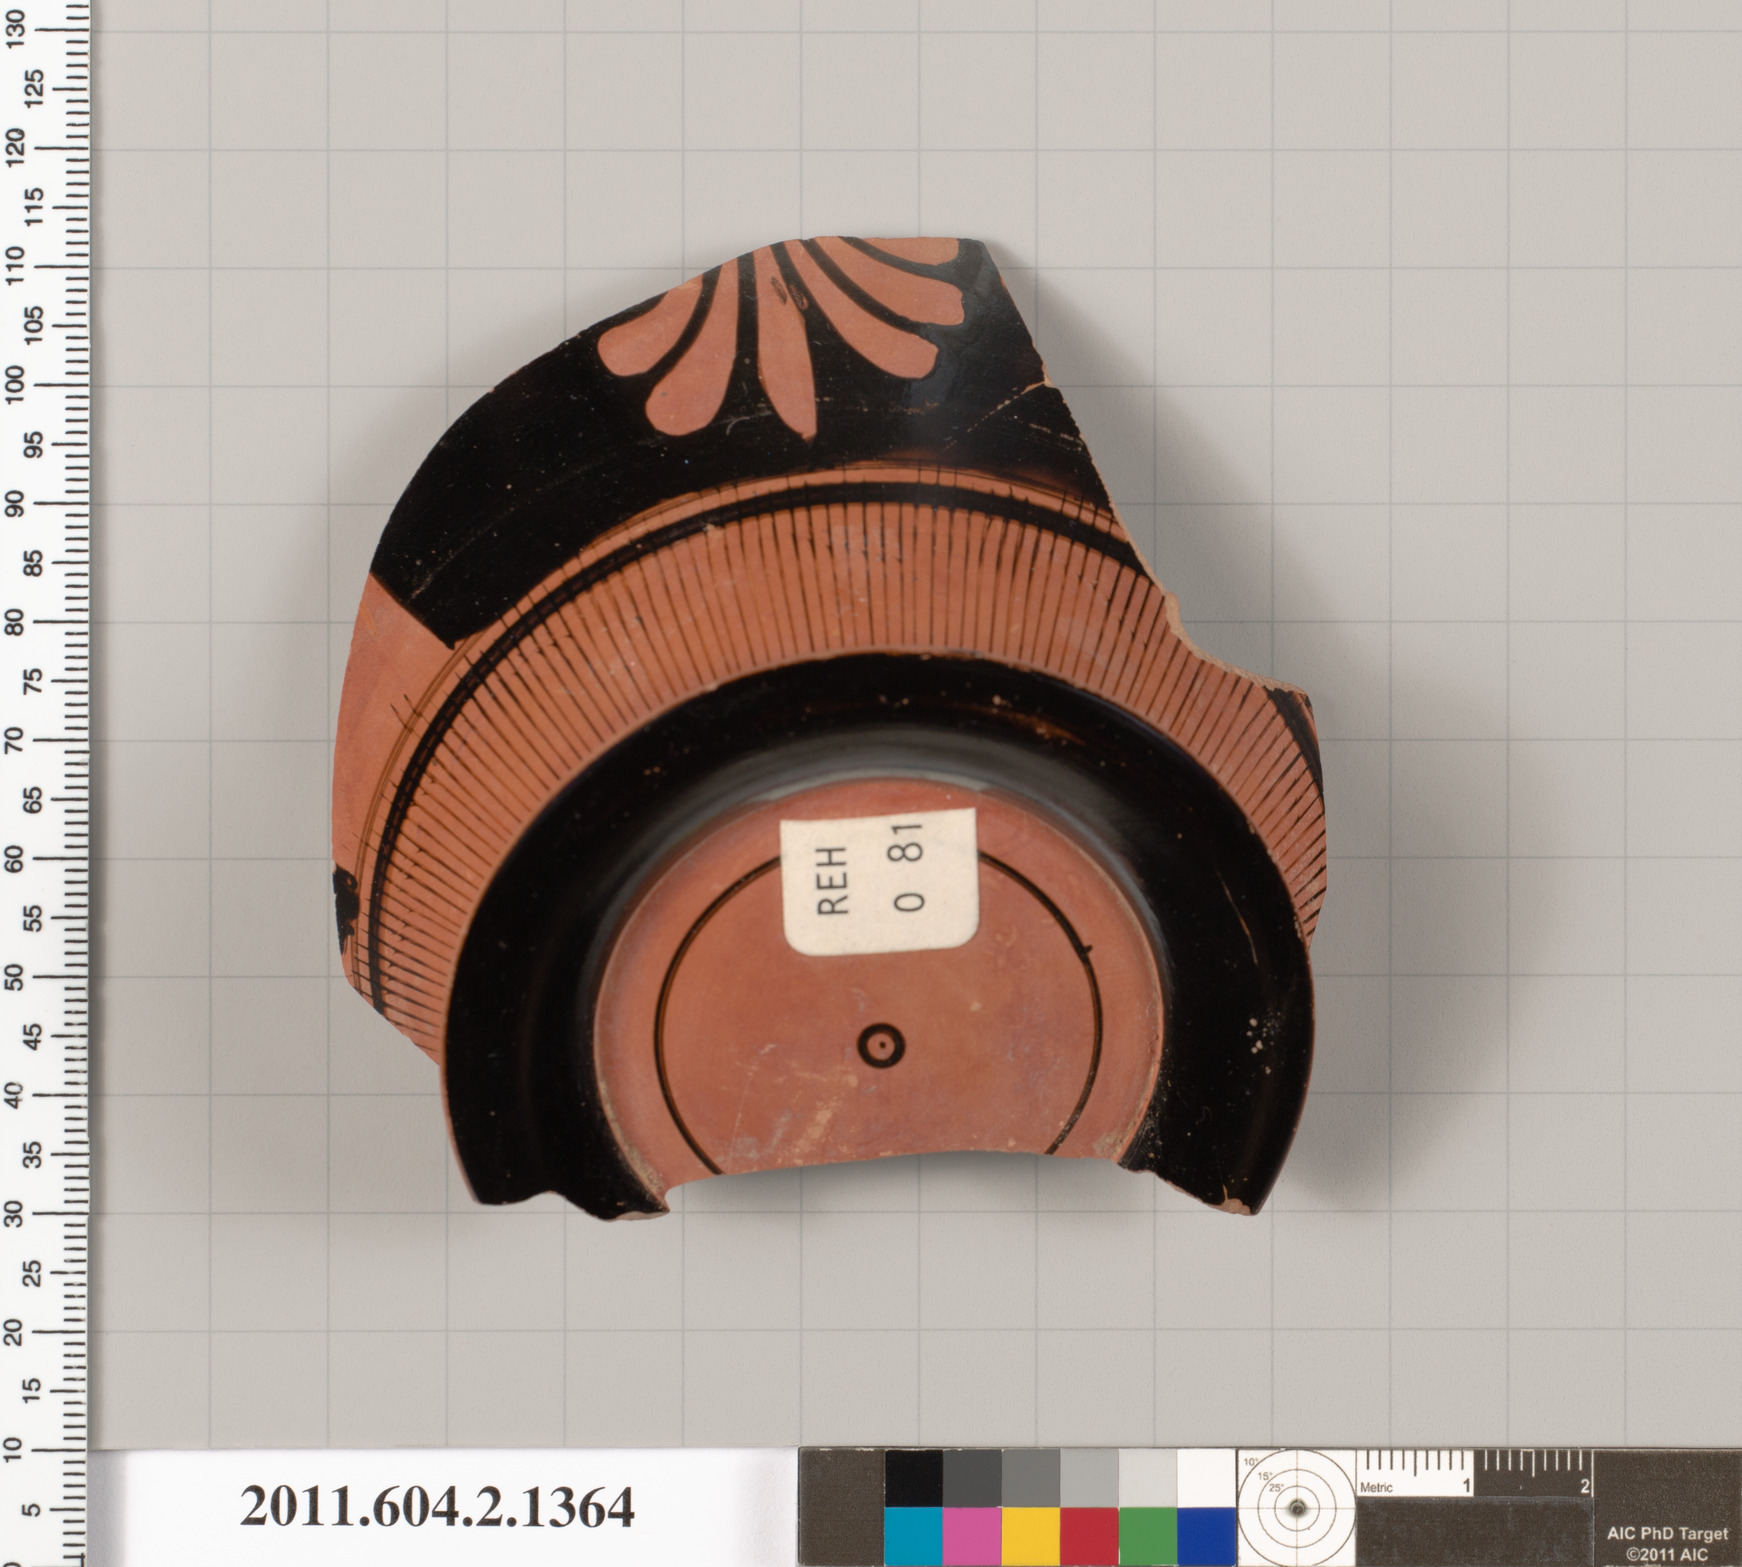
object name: skyphos fragment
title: Terracotta fragment of a skyphos (deep drinking cup)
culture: greek, attic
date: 470-460 BCE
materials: terracotta